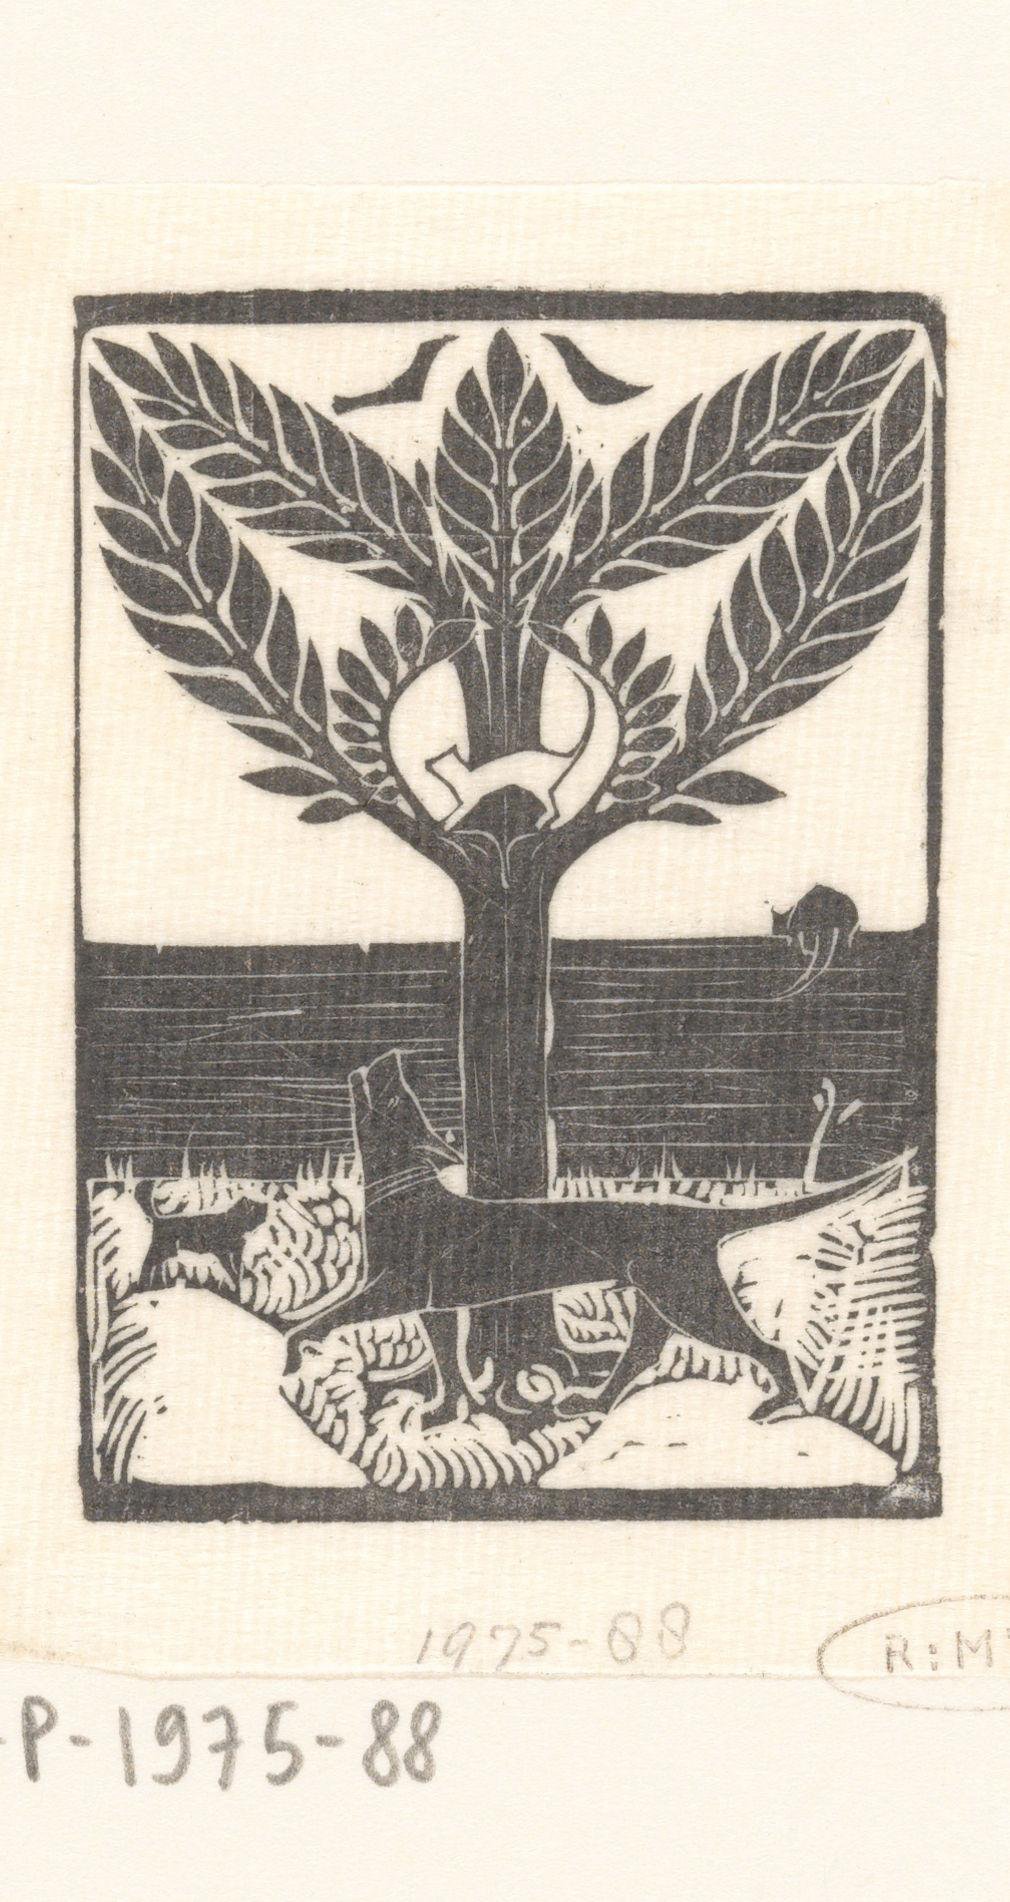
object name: illustration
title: Blaffende hond onder een boom met een kat erin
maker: karel petrus cornelis de bazel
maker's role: draughtsman, print maker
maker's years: 1869-1923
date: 1912-1934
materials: paper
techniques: woodcut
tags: trees, cat, dog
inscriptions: collector's mark: Lugt 2228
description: Op de achtergrond een schutting waar een kat op zit.